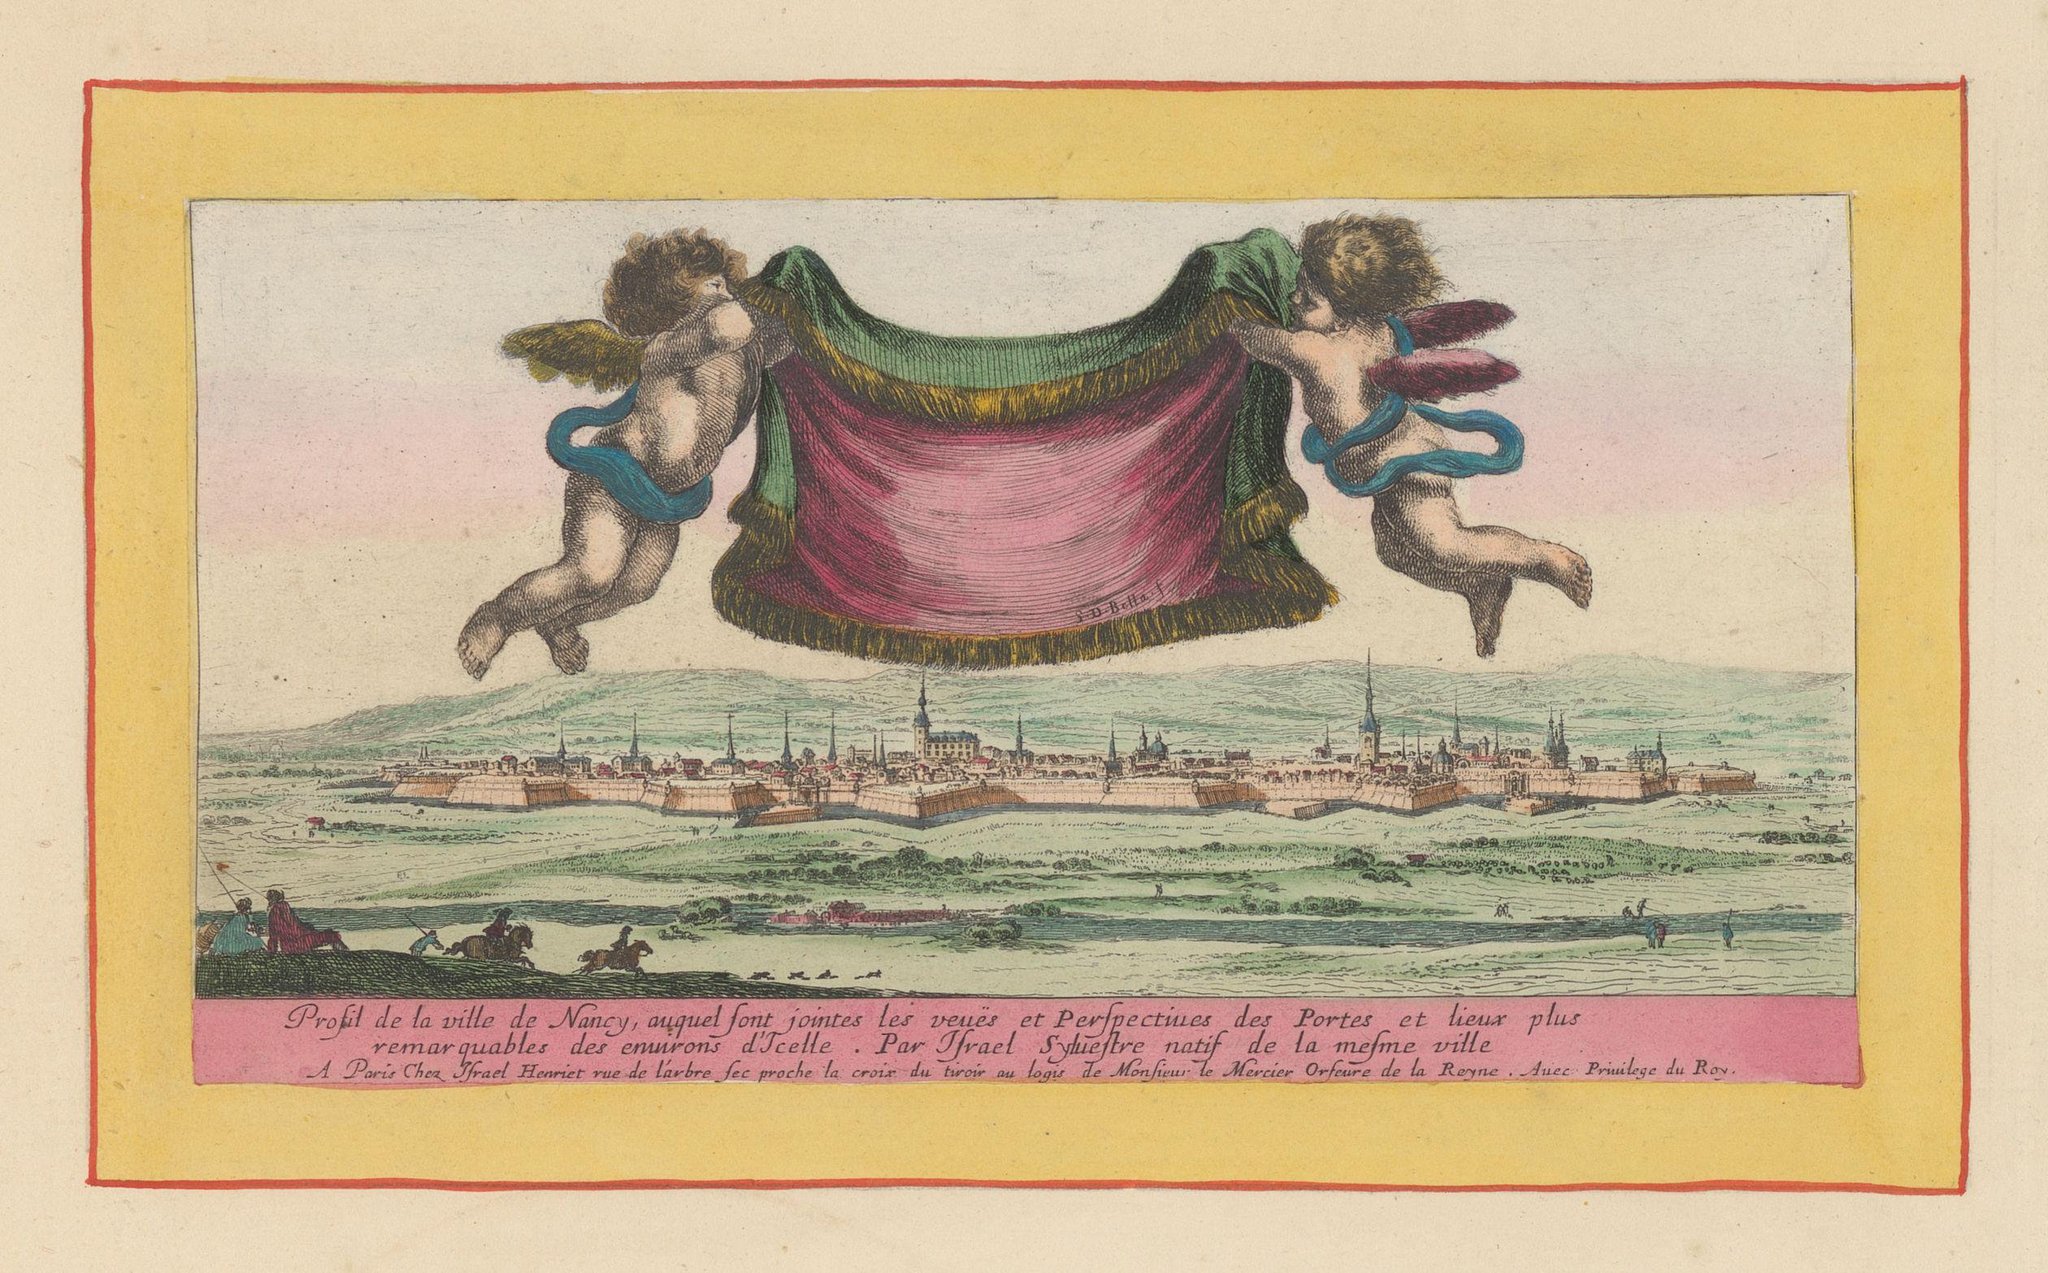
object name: album leaf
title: Gezicht op Nancy met daarbij de stadspoorten en opvallende plaatsen aldaar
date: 1631-1661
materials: paper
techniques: etching, hand coloring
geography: the hague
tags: city-view in general; 'veduta'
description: Boven de stad vliegen twee putti die een banier vasthouden. Deze prent maakt deel uit van een album.